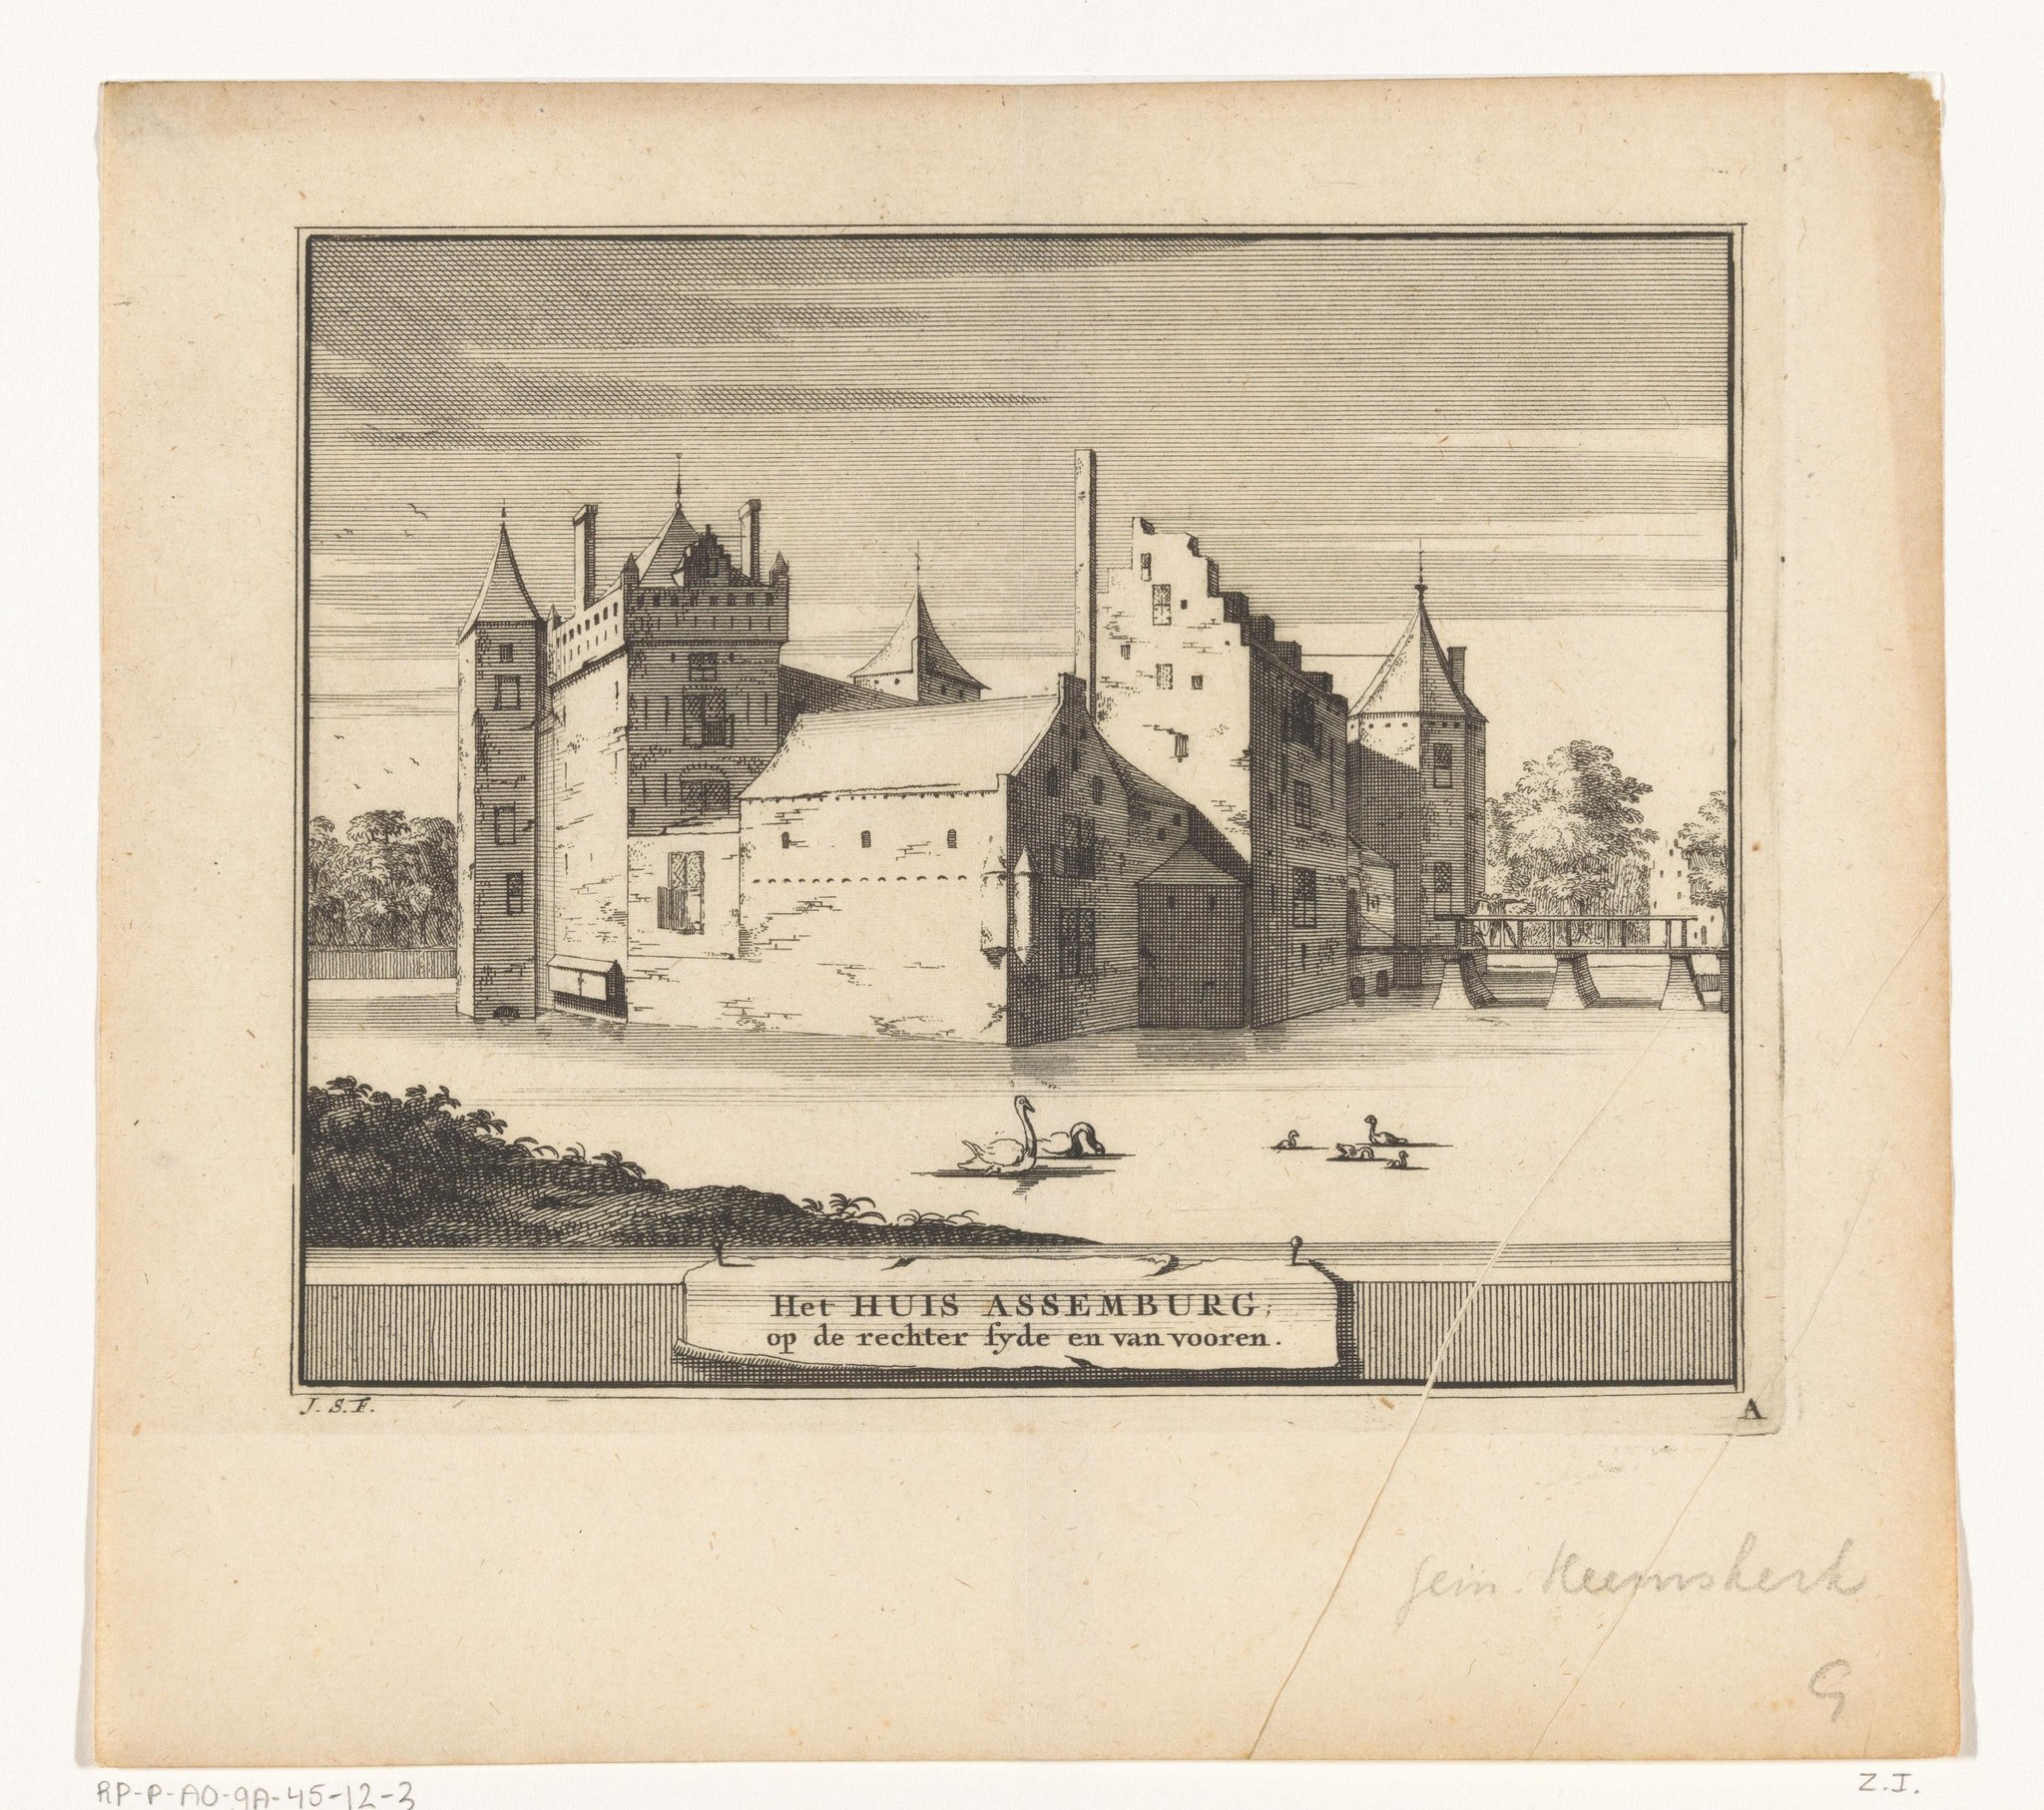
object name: print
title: Gezicht op Kasteel Assumburg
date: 1711-1774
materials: paper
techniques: engraving, etching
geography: amsterdam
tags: castle, bridge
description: Prent ook gebruikt in: Smids, Ludolf. Schatkamer der Nederlandsse oudheden; of woordenboek, behelsende Nederlands steden en dorpen, kasteelen, sloten en heeren huysen (…). Amsterdam: Pieter de Coup, 1711, tussen p. 22 en 23. Het is ook mogelijk dat deze prent uit de tweede (1737) of derde (1774) druk komt, of uit een uitgave met alleen de prenten: Nederlandsche oudheden, bestaande in zestig verbeeldingen (...) gelegen in Holland, 't Sticht van Utrecht en Gelderland enz. Amsterdam: Hendrik Bosch, 1721.